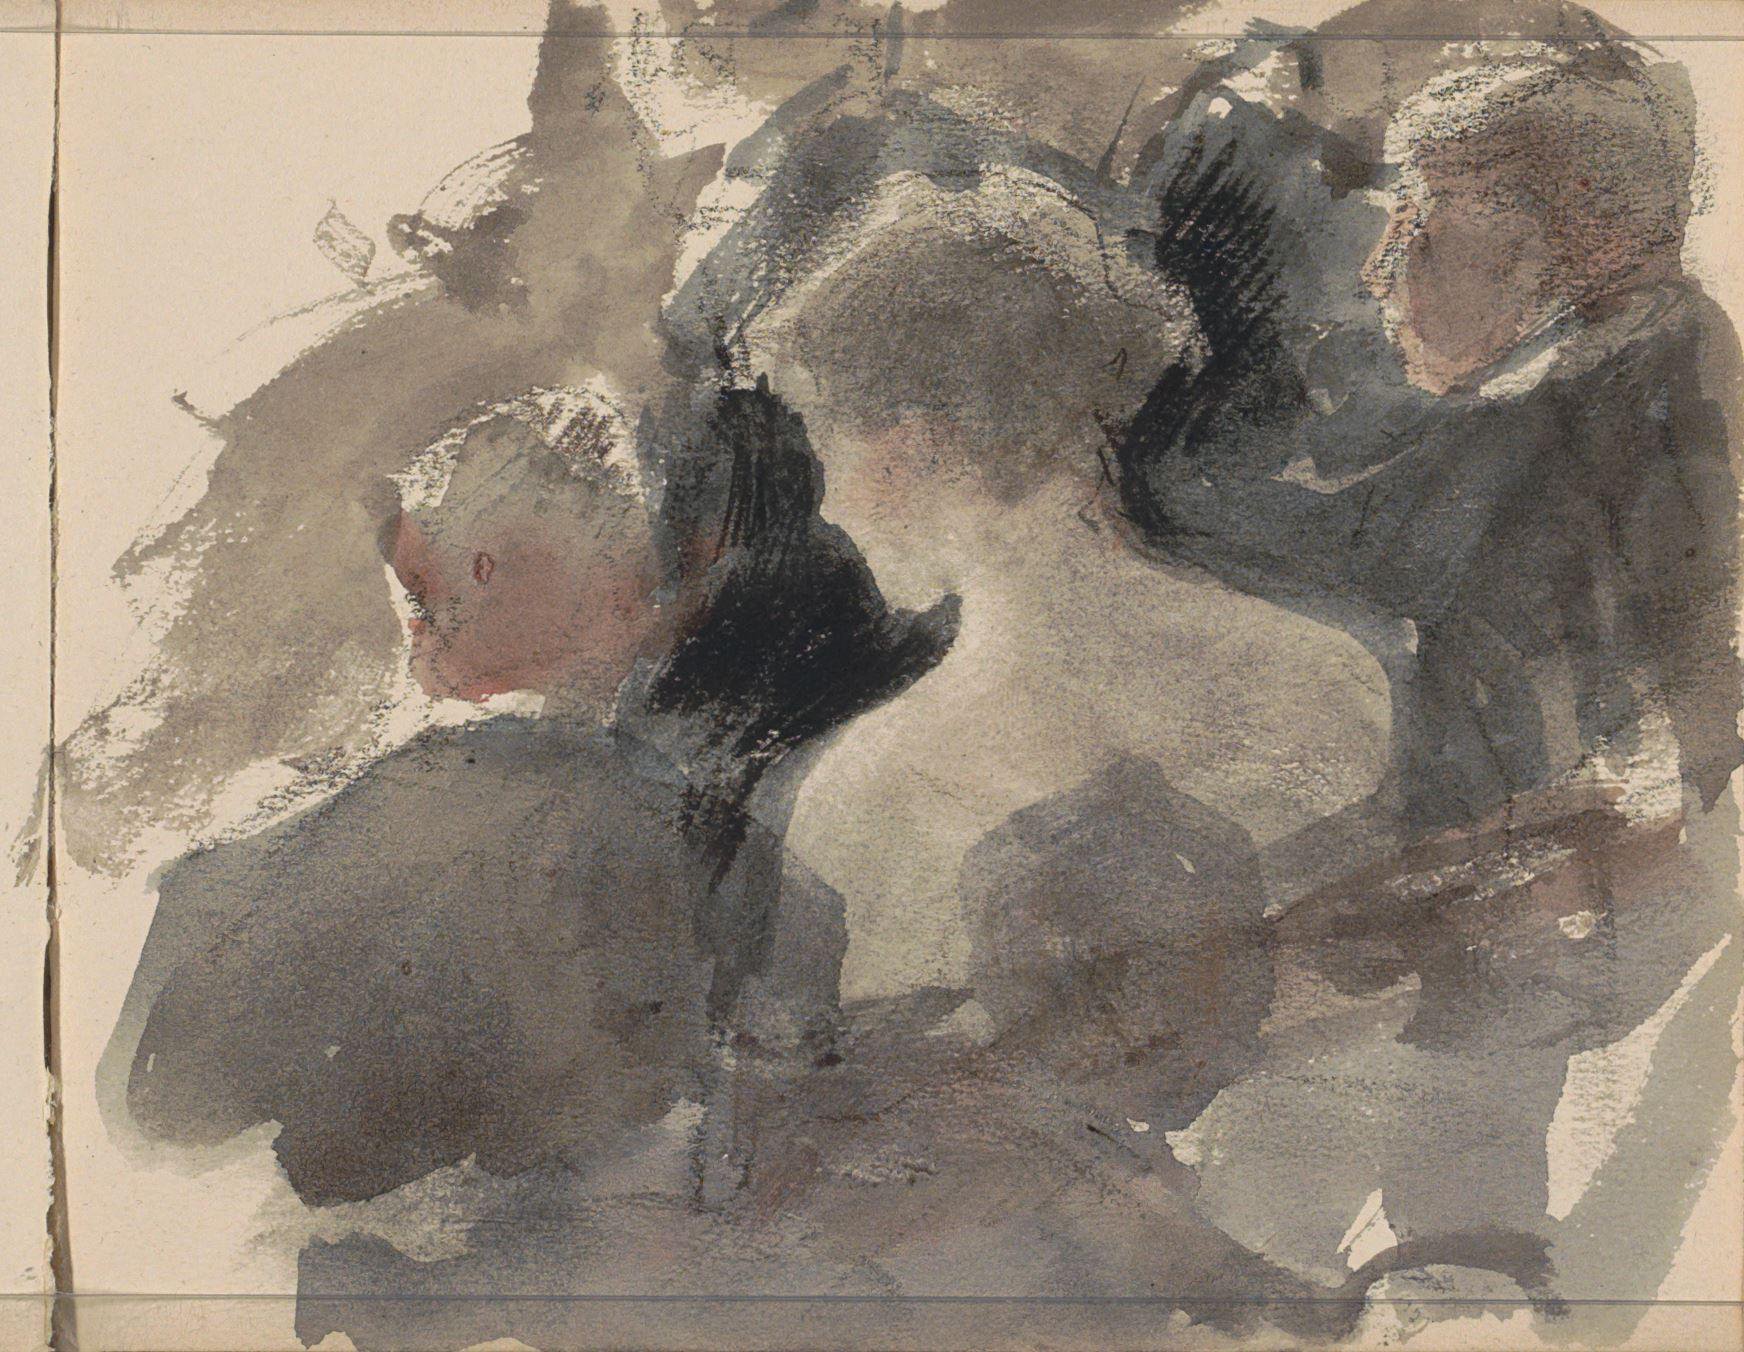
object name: sketchbook leaf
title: Figuren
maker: johan antonie de jonge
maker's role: draughtsman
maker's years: 1864-1927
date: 1881-1927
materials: chalk, paper, watercolor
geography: south holland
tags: adult man (+ two persons), adult woman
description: Figuren, mogelijk twee mannen en een vrouw. Blad 15 uit een schetsboek met 29 bladen.